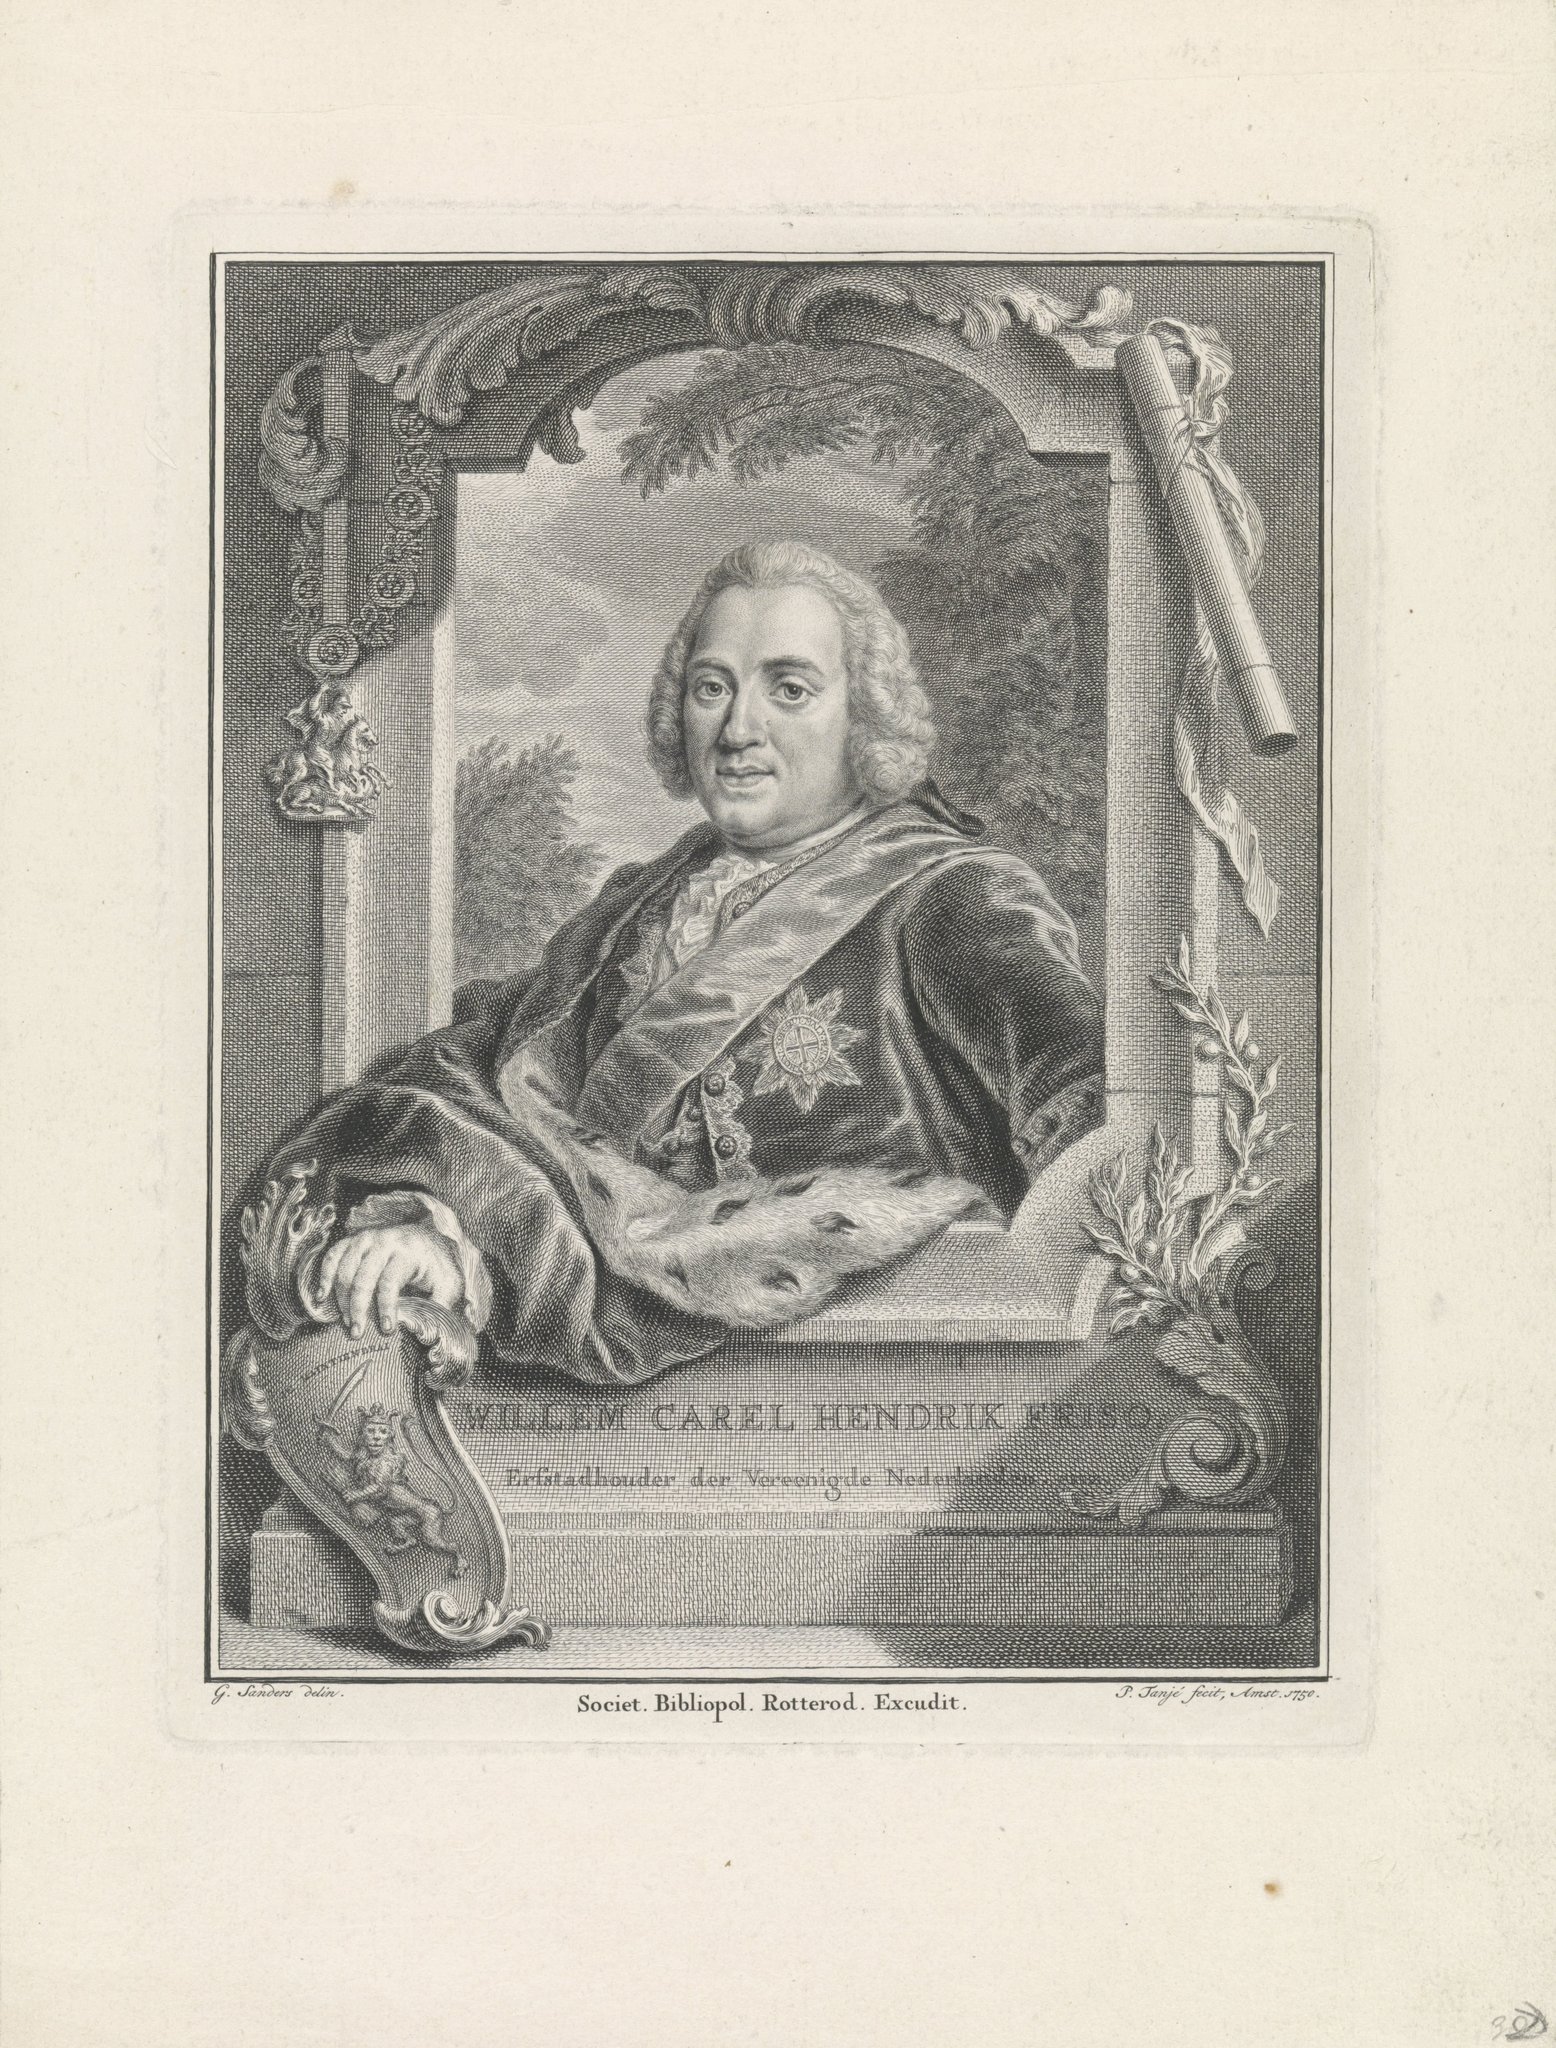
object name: print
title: Portret van prins Willem IV van Oranje-Nassau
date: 1750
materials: paper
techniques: engraving, etching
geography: rotterdam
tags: the hague, willem iv (prins van oranje-nassau)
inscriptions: collector's mark: Lugt 240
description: Willem IV, prins van Oranje-Nassau en stadhouder, gezien door een venster, met een hermelijnen mantel over een schouder. Hij toont het Nederlands wapenschild.